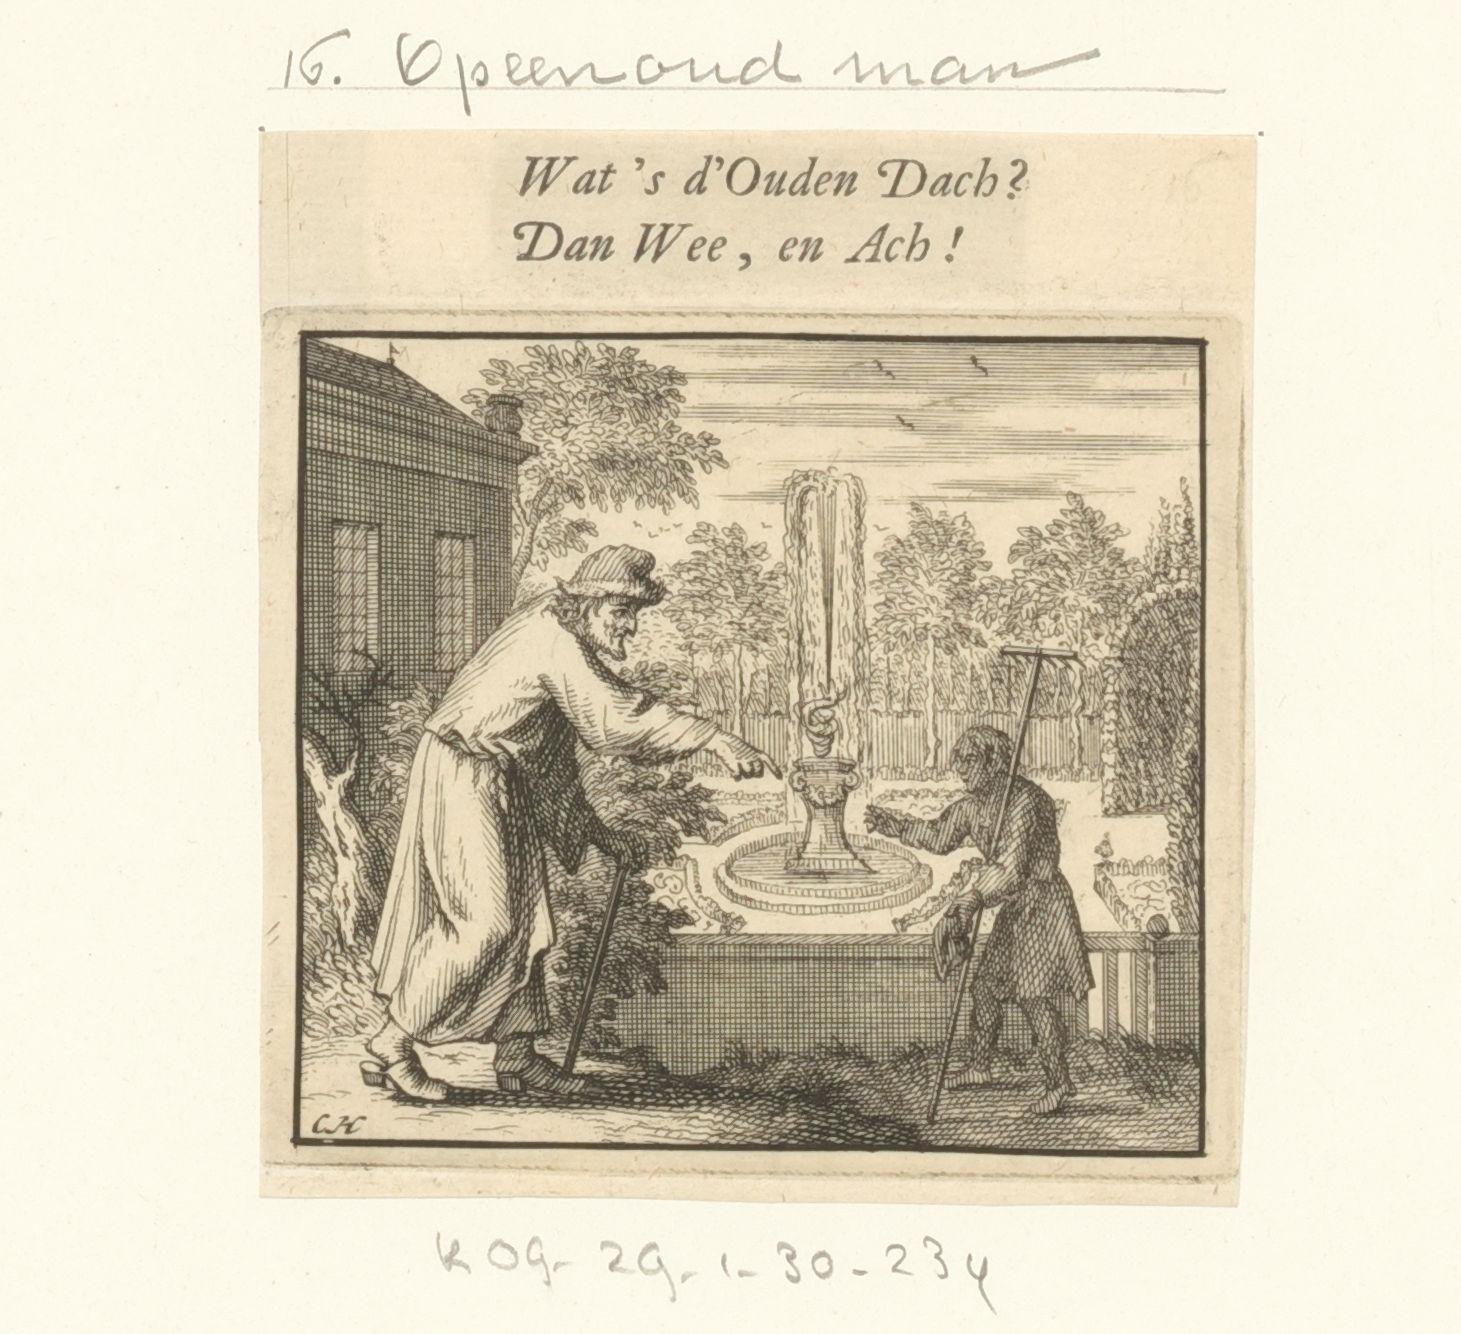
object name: print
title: Wat 's d'Ouden Dach? Dan Wee, en Ach!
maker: cornelis huyberts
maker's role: print maker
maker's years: 1669-1709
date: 1725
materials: paper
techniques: etching, letterpress printing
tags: child, old man, fountain of youth, 'fontaine de jouvence'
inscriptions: stamp, collector's mark: Lugt 1641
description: Prent uit: Graauwhart, Hendrik. Voorbeeldelyke zeede-lessen, genoomen uyt den eersten toestand des werelds (...). Amsterdam: Johannes Ratelband, 1725. Prent ook gebruikt voor eerdere en (1709) latere uitgave (1756, 1761 en 1764).